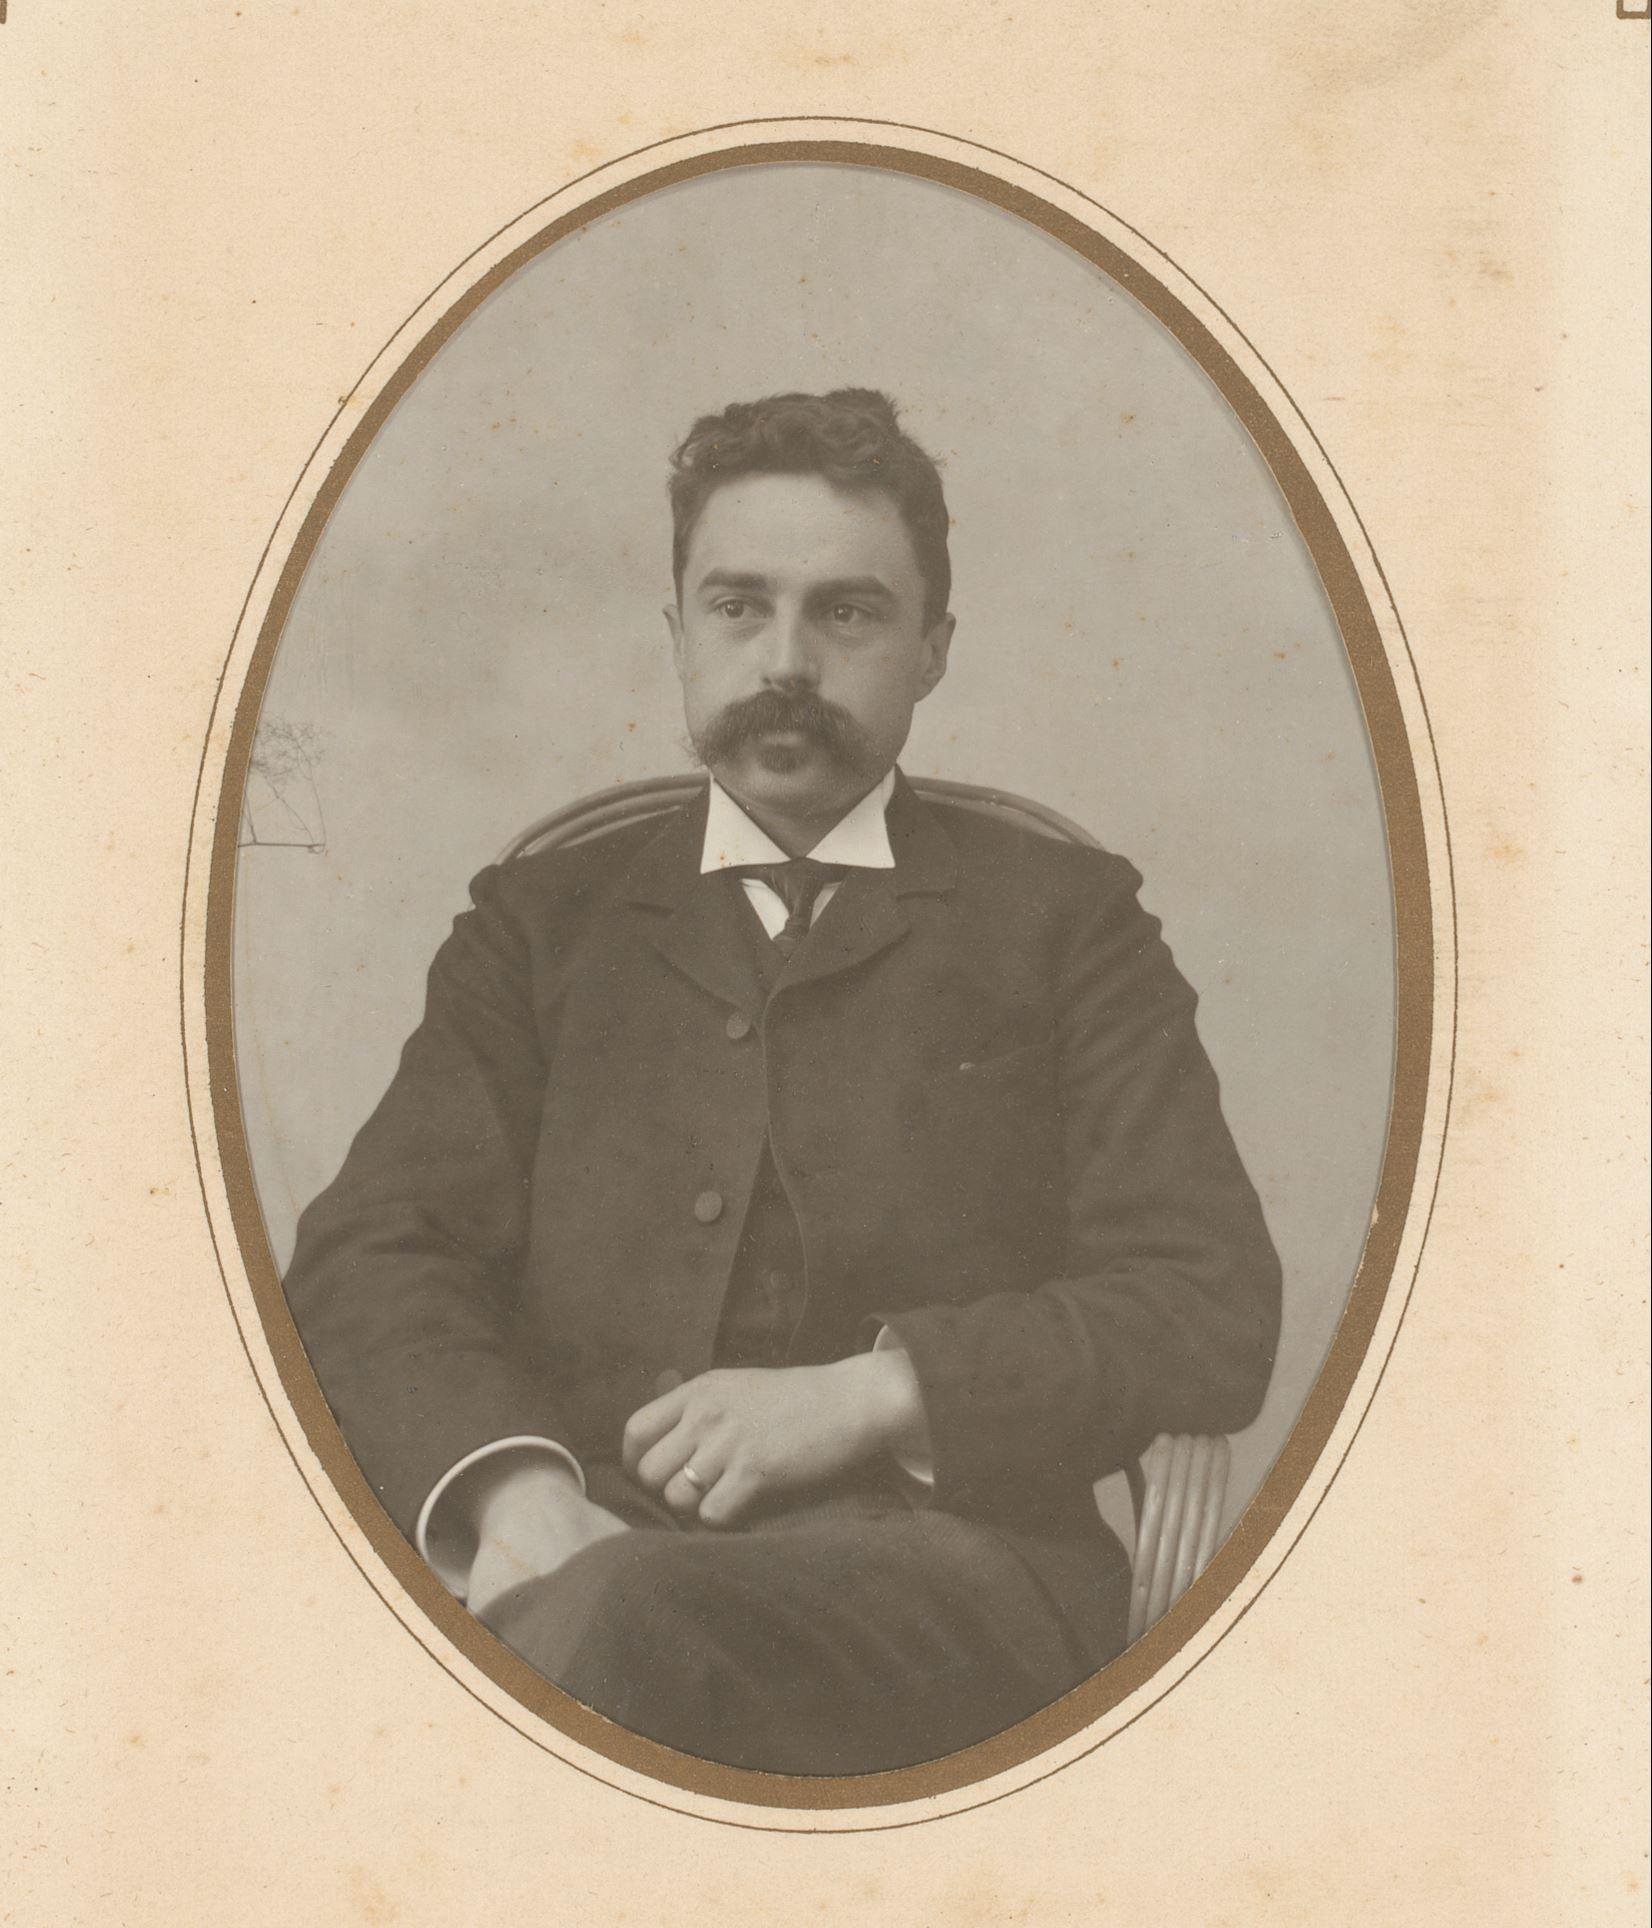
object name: album leaf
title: Portret van een man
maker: Anonymous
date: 1880-1920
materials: cardboard, photographic support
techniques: collodion silver print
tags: moustache, adult man, historical persons